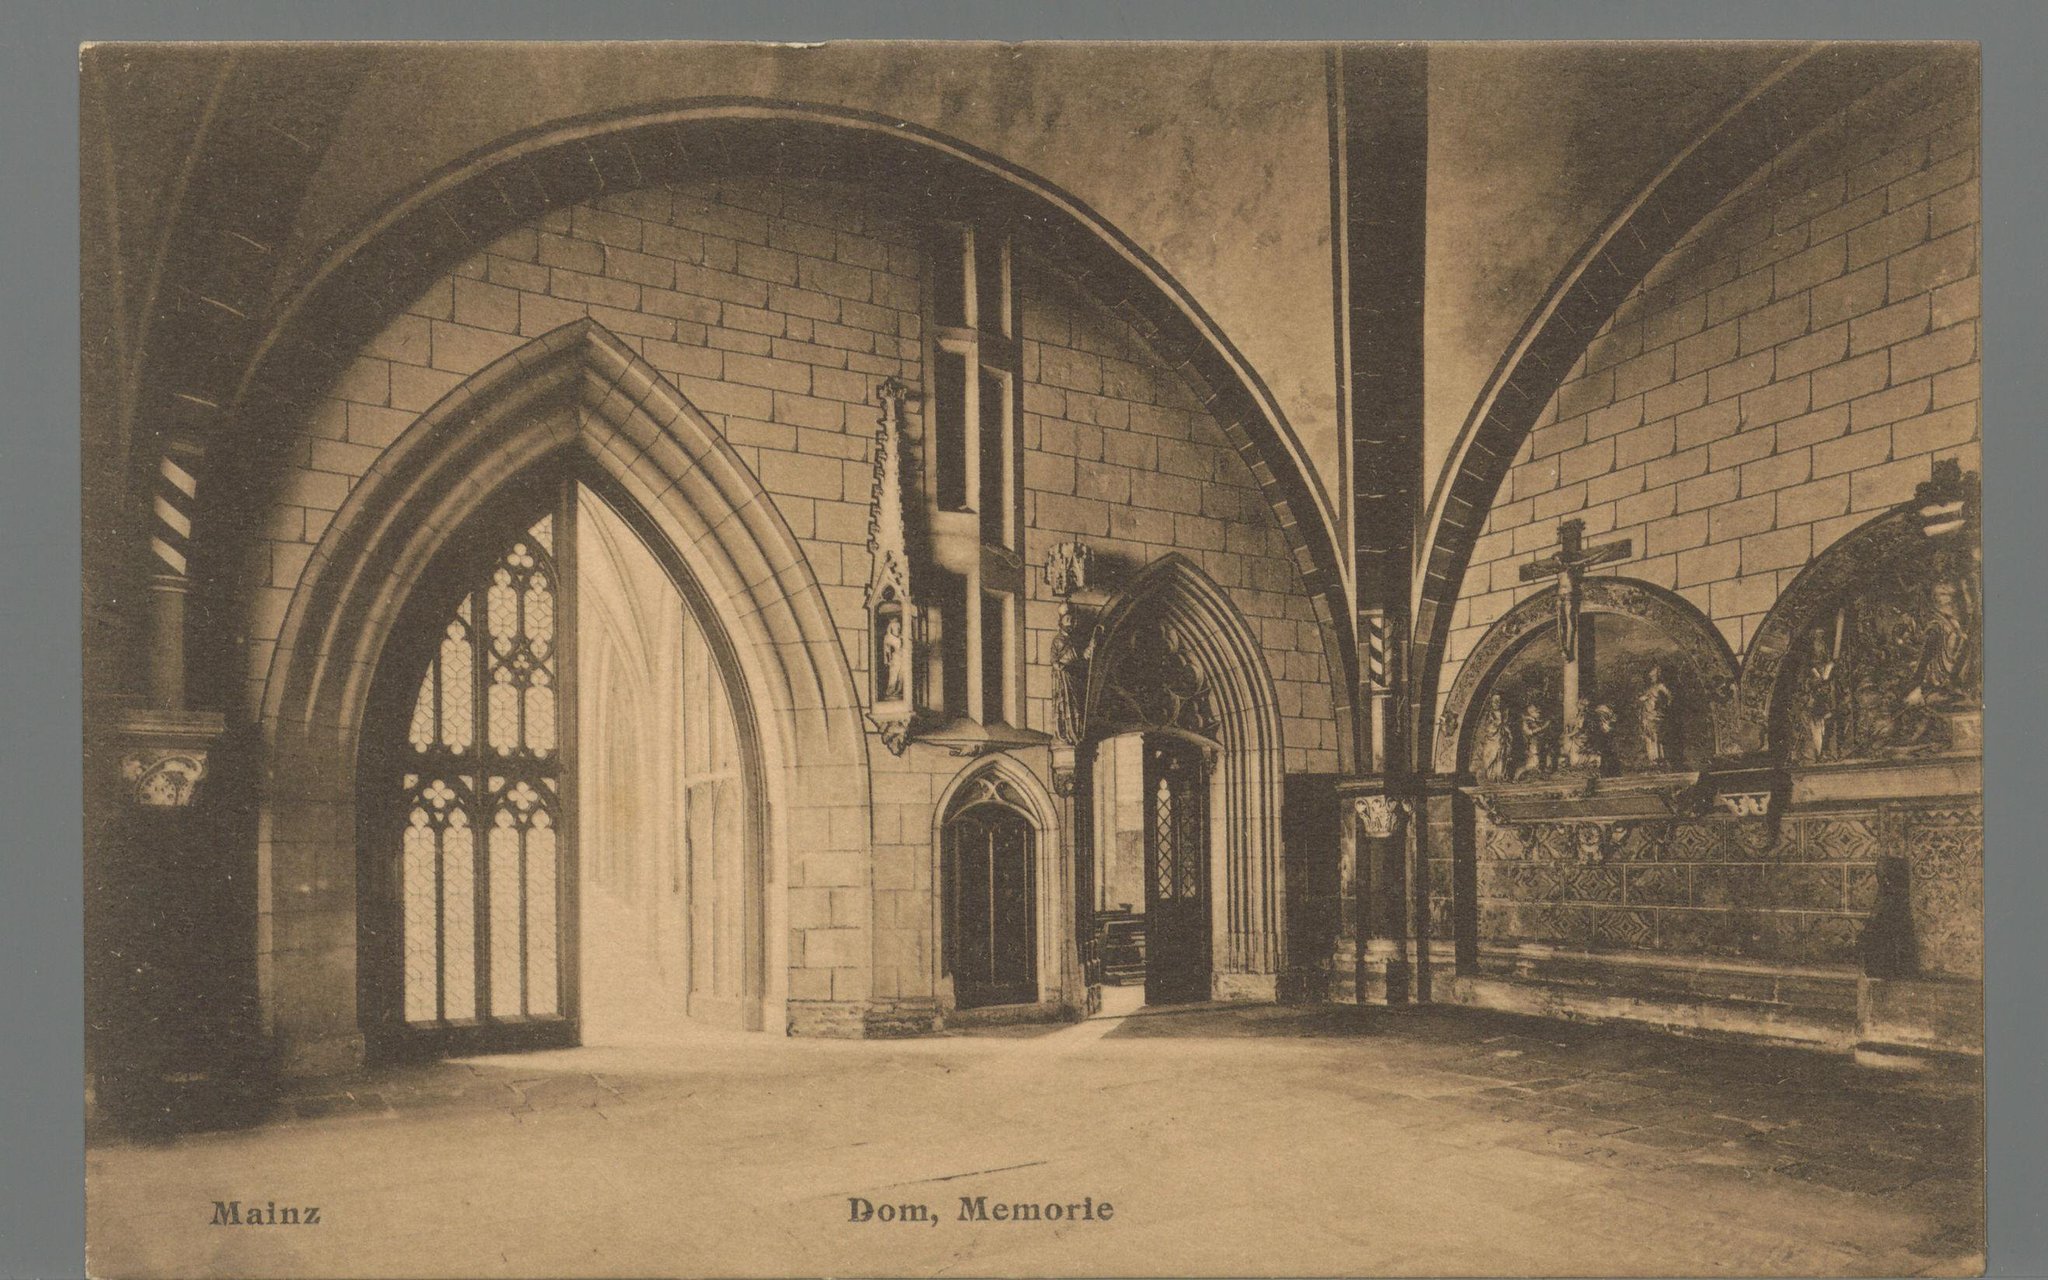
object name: photomechanical print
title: Mainz. Dom, Memorie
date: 1906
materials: cardboard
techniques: photograph, writing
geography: mainz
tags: interior of church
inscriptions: date